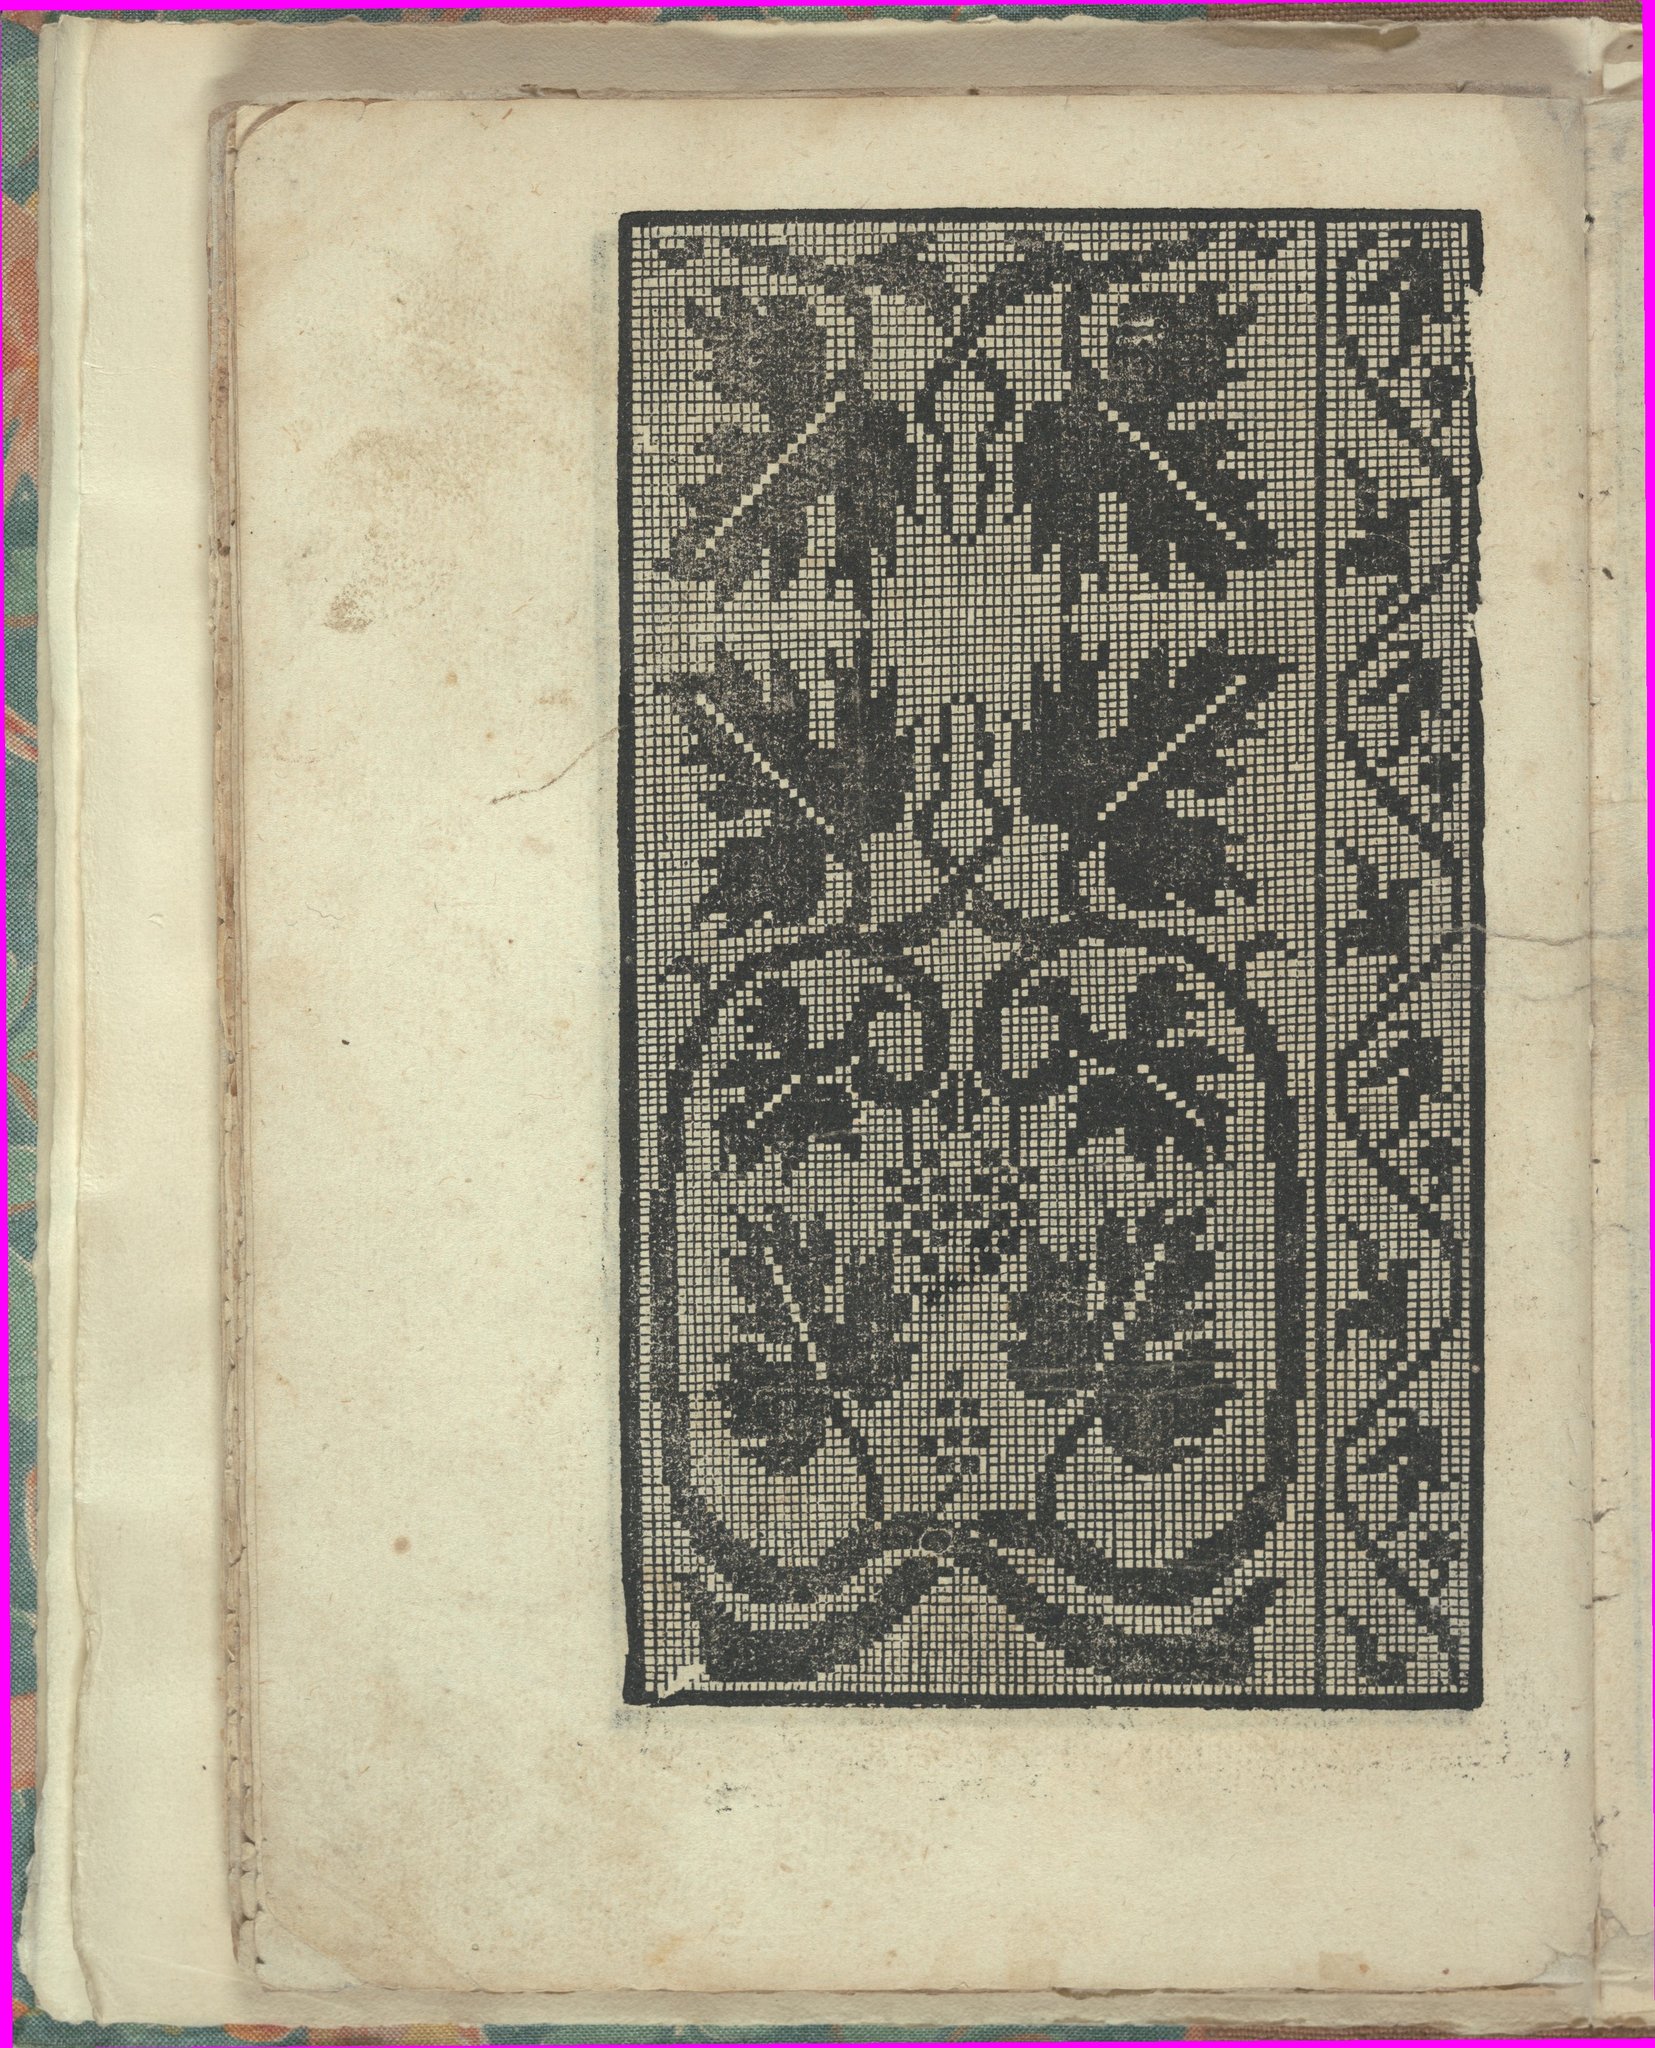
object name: book print ornament architecture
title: Opera Nova Universali intitulata Corona di racammi, page 34 (verso)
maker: giovanni andrea vavassore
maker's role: publisher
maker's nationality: italian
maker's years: 1530-1573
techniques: woodcut